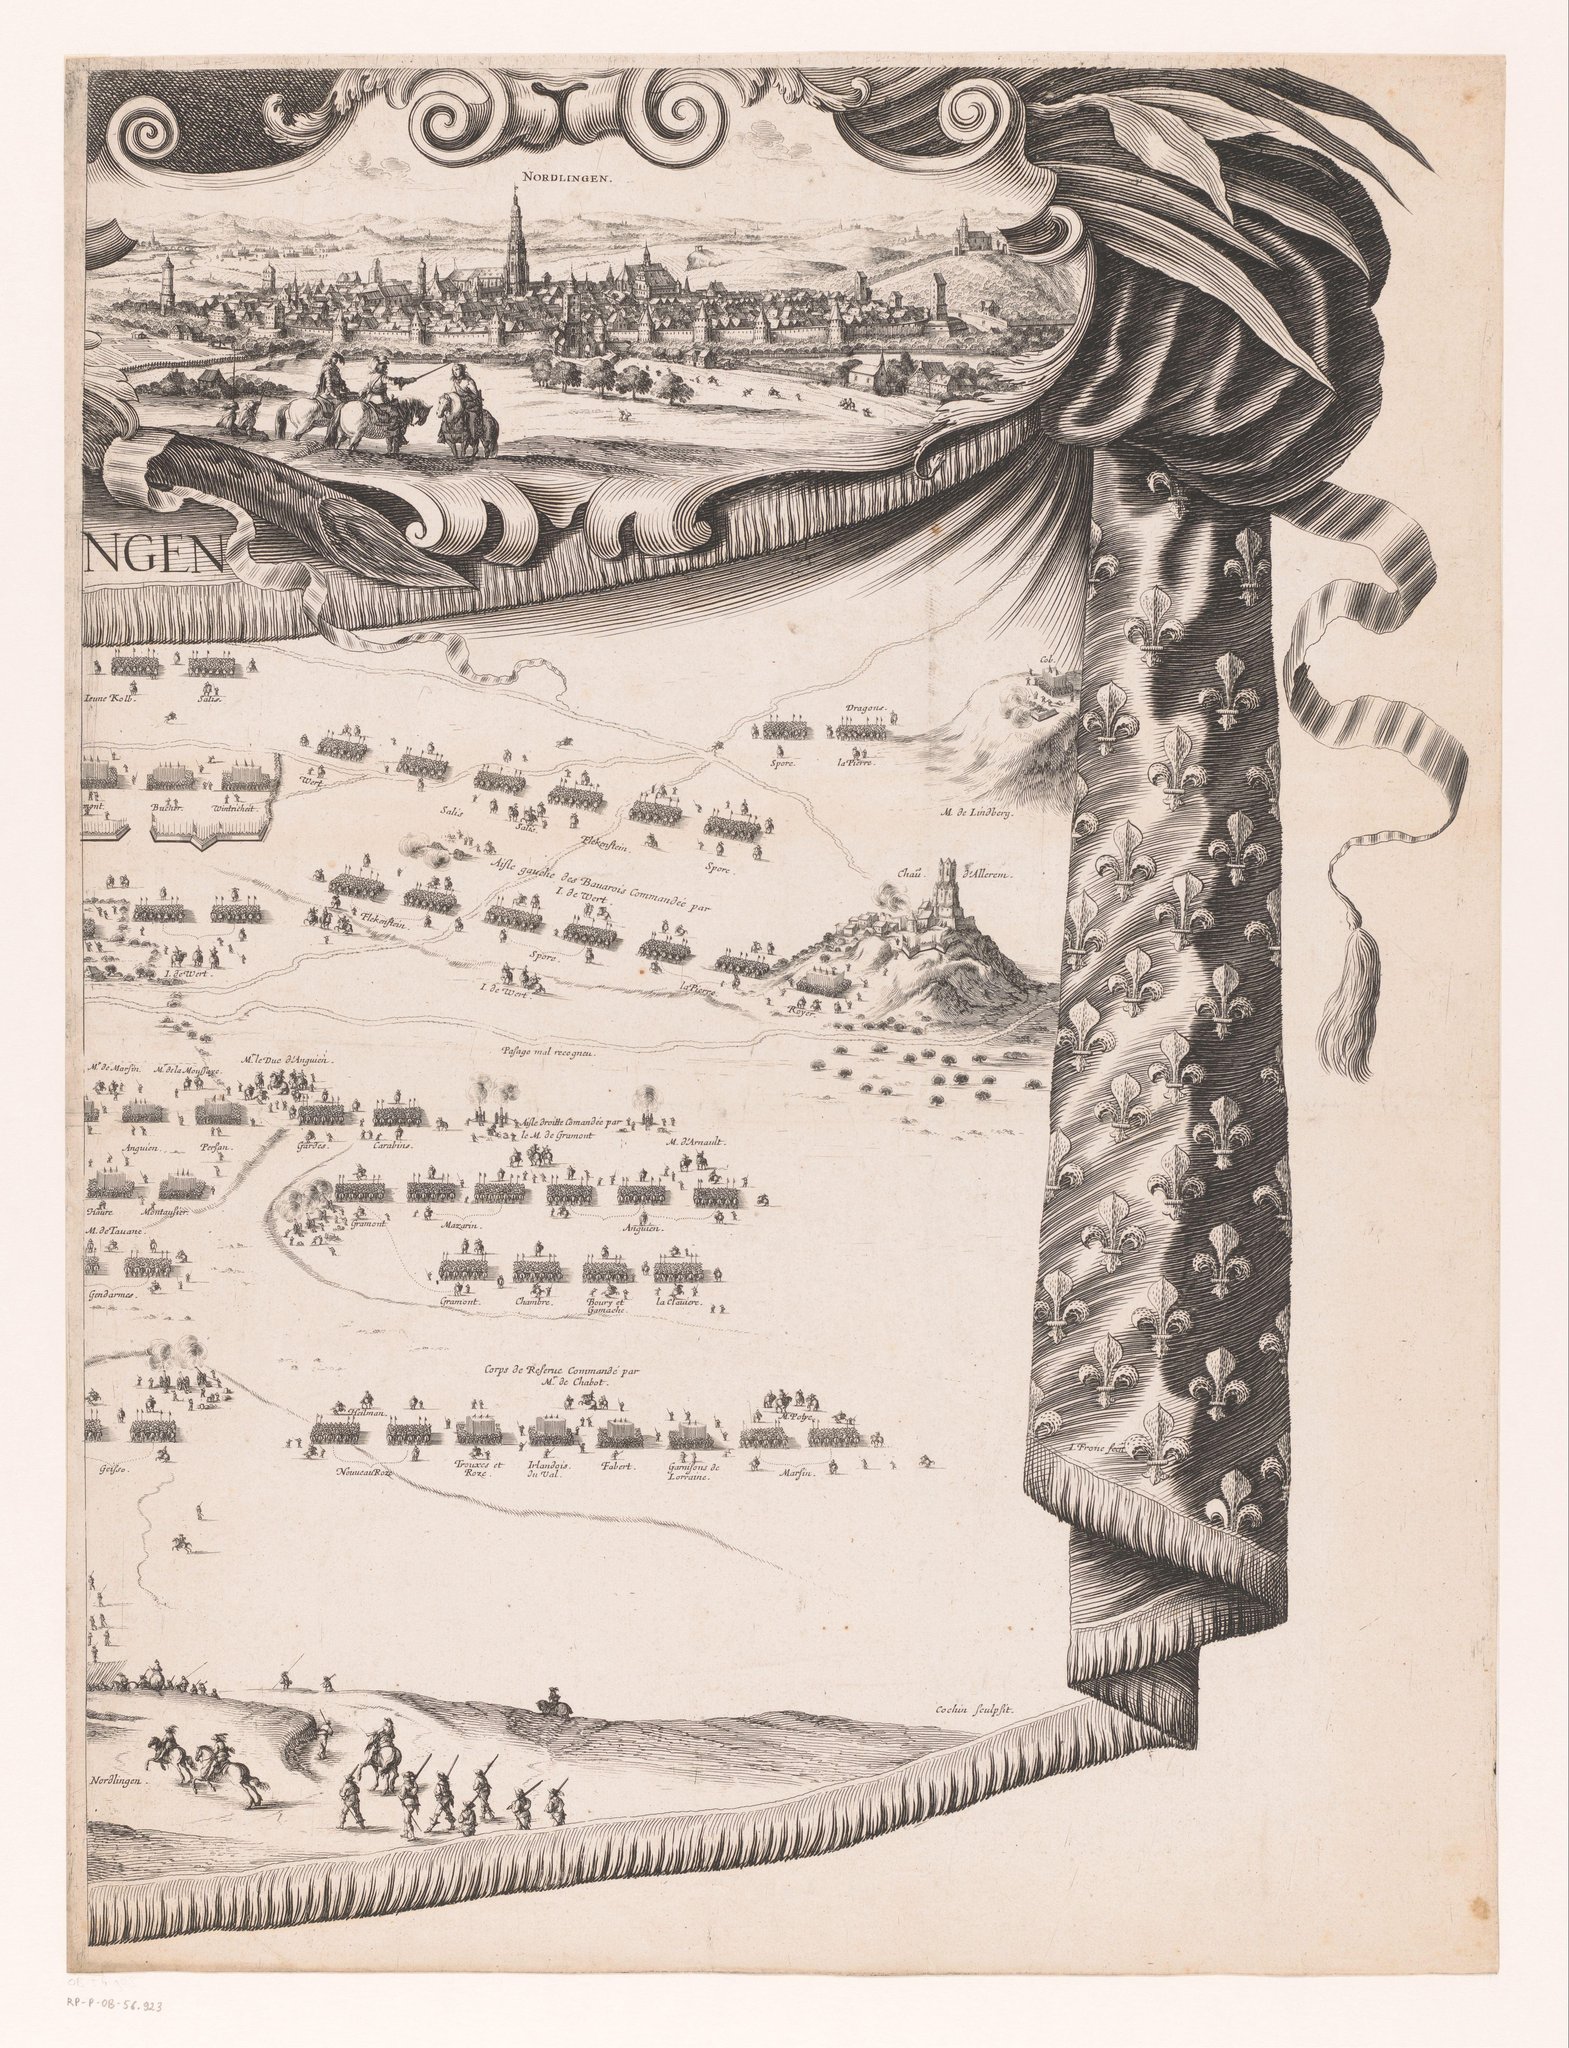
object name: print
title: Opstelling van het leger bij slag bij Nördlingen (rechterdeel)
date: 1646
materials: paper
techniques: engraving, etching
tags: battle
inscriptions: collector's mark: Lugt 2228, collector's mark: Lugt 240